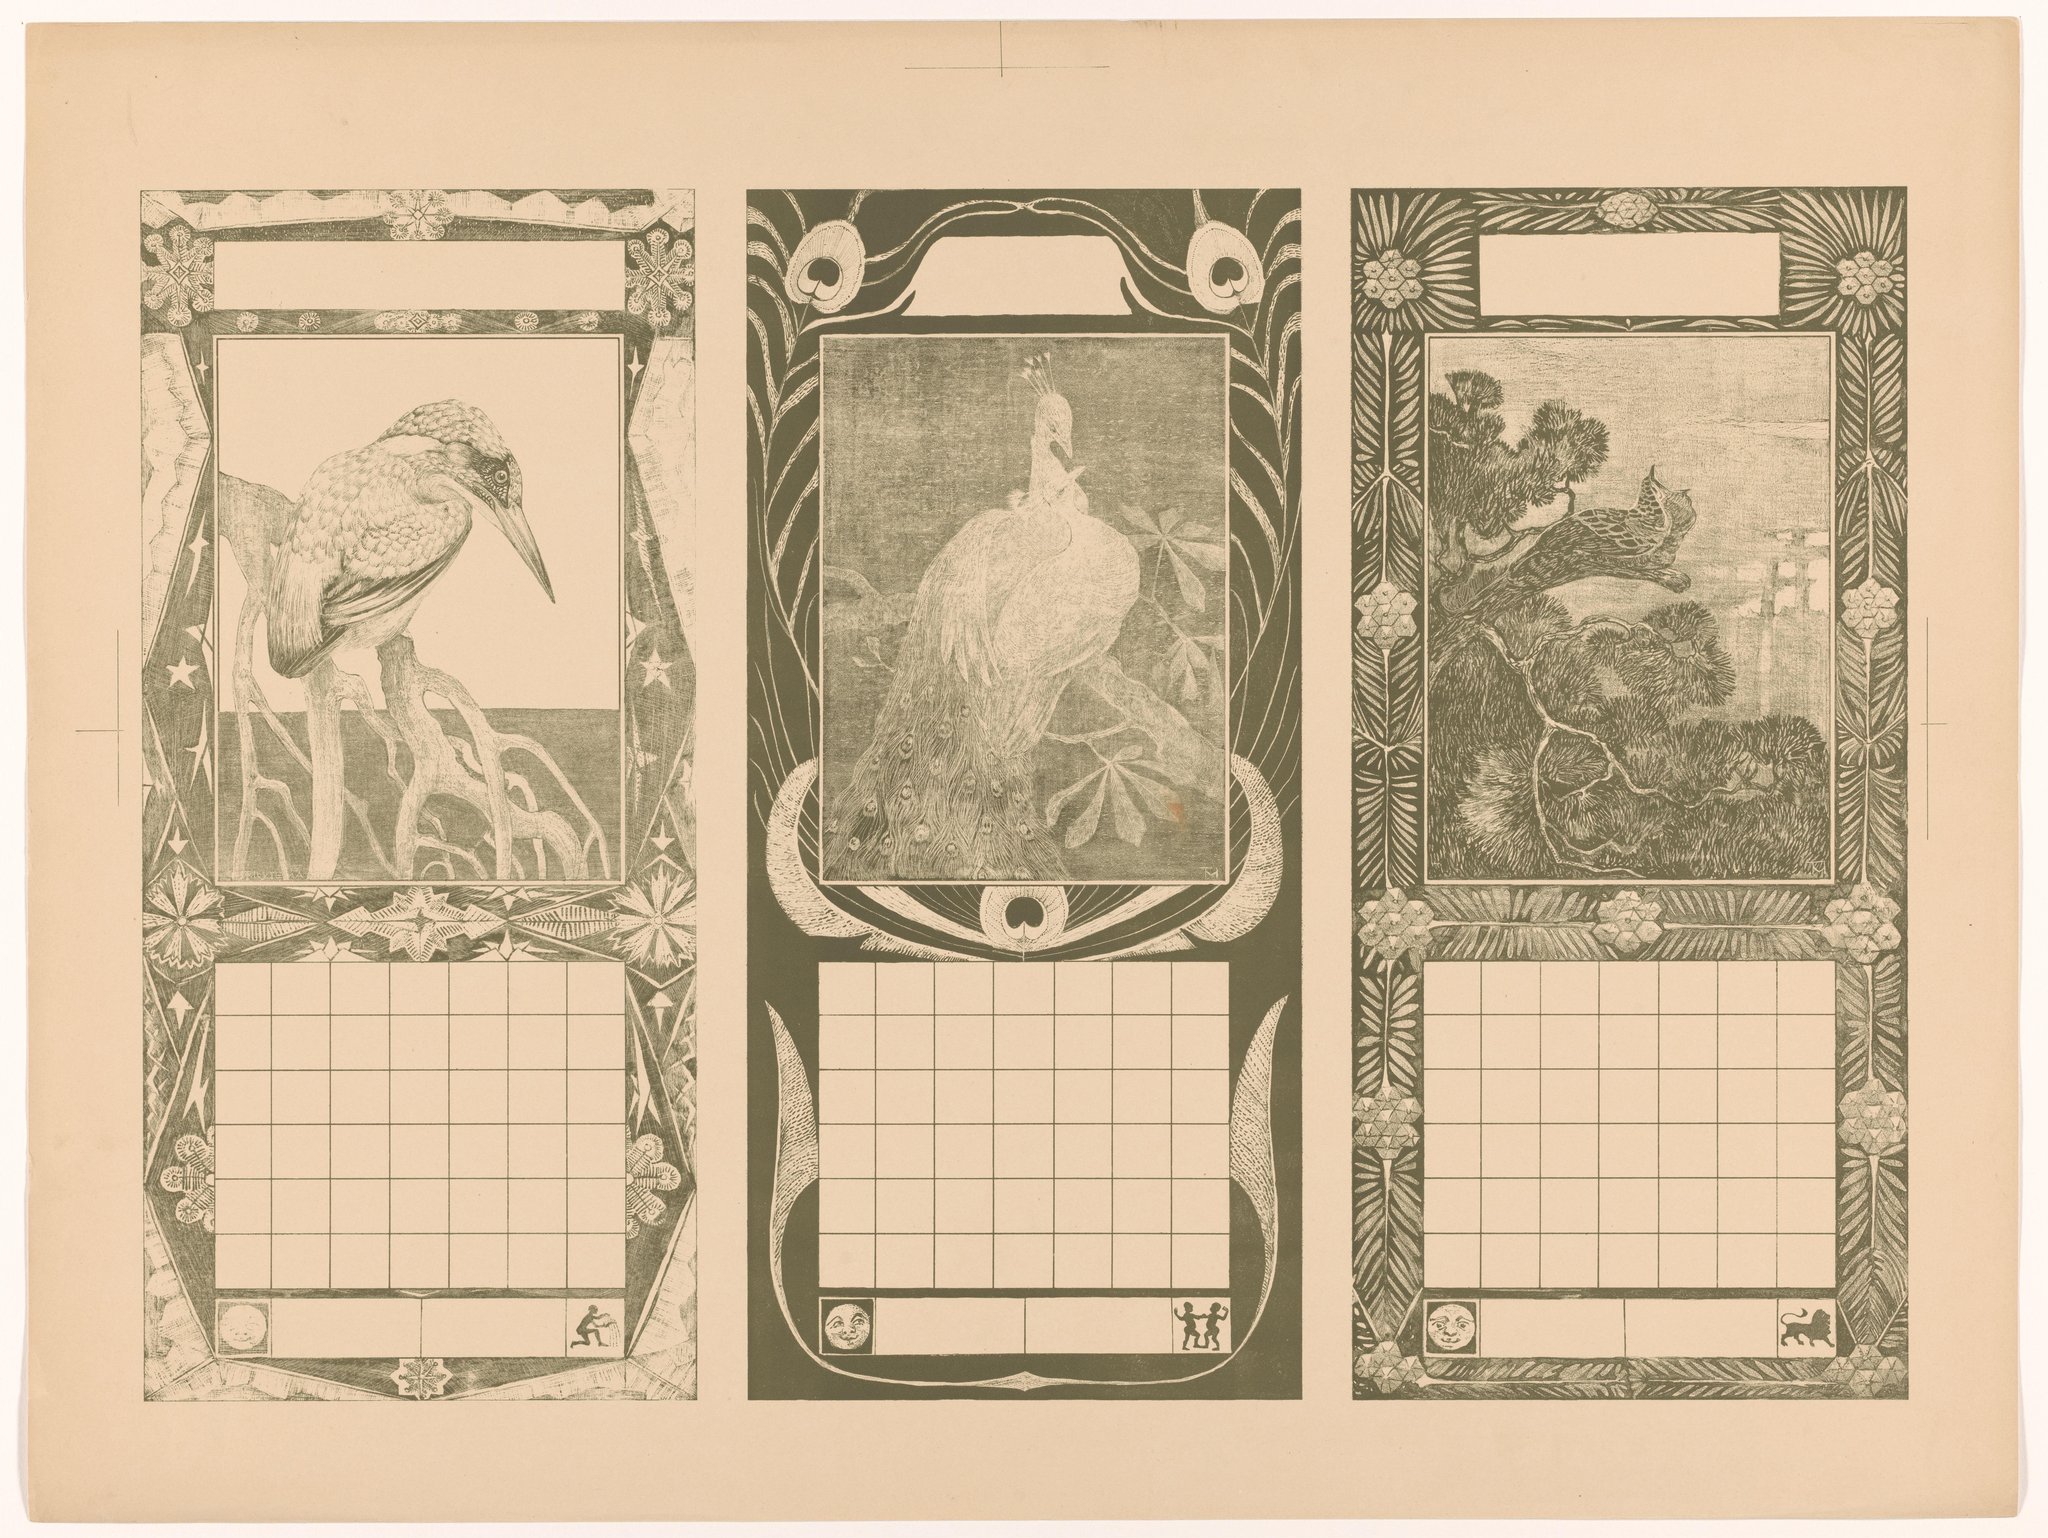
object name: print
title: Kalenders voor januari, mei en juli 1904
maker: theo van hoytema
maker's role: draughtsman, painter, print maker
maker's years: 1863-1917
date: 1904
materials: paper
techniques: lithograph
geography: amsterdam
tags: calendar, almanac, song-birds: swallow, ornamental birds: peacock, other birds: kingfisher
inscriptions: collector's mark: Lugt 2233